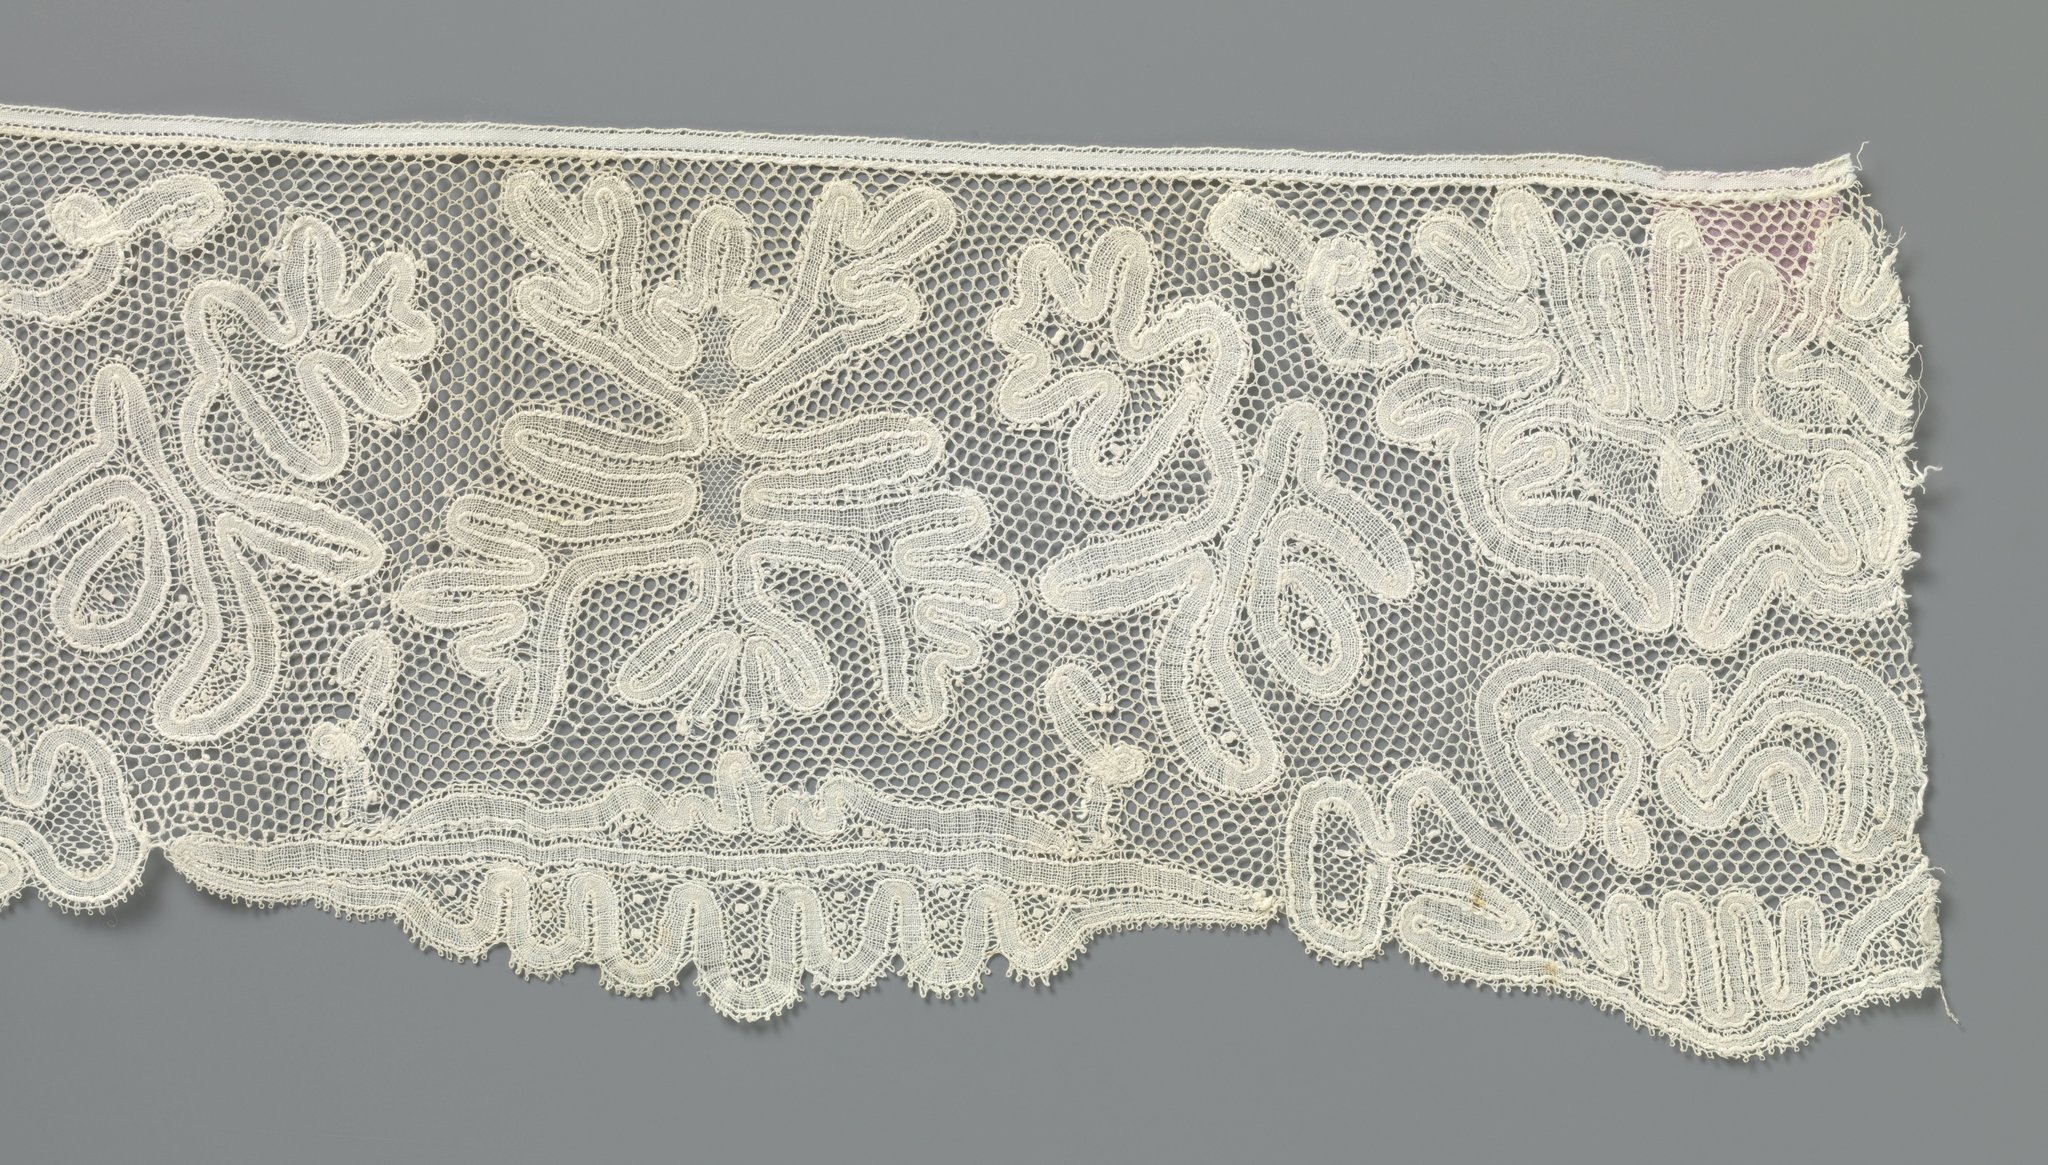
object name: strip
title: Strook kloskant met brede bloemkelk en gestileerde dubbelkoppige adelaar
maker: Anonymous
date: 1885-1899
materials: linen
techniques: lace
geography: eastern europe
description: Strook naturelkleurige kloskant: Oosteuropese kant (lintkant). Het patroon bestaat uit twee min of meer symmetrische composities waarbij de contouren van de motieven zijn gemaakt met kronkelende gekloste linten, die minimaal in breedte variëren. De ene compositie bestaat uit een grote en brede bloemkelk, met los daaronder een korte steel en eenvoudige voluutbladeren. De andere compositie bestaat uit een hangende bloem met een veel kleinere en eenvoudig vormgegeven bloemkelk, en gelobde bladeren als vleugels van een vogel, mogelijk betreft het dan ook geen bloem maar een gestileerde dubbelkoppige adelaar. De motieven zijn met elkaar verbonden door een traliegrond, een ronde Valenciennes-grond. De linten zijn gemaakt in linnenslag met aan beide zijden van het lint dikkere en glimmende contourdraden. Binnen de contouren van linten zijn siergronden toegepast, waaronder een netslagvulling en een Mechelse grond versierd met moesjes gemaakt in vormslag. De bovenzijde is afgewerkt met een geweven linnen bandje.